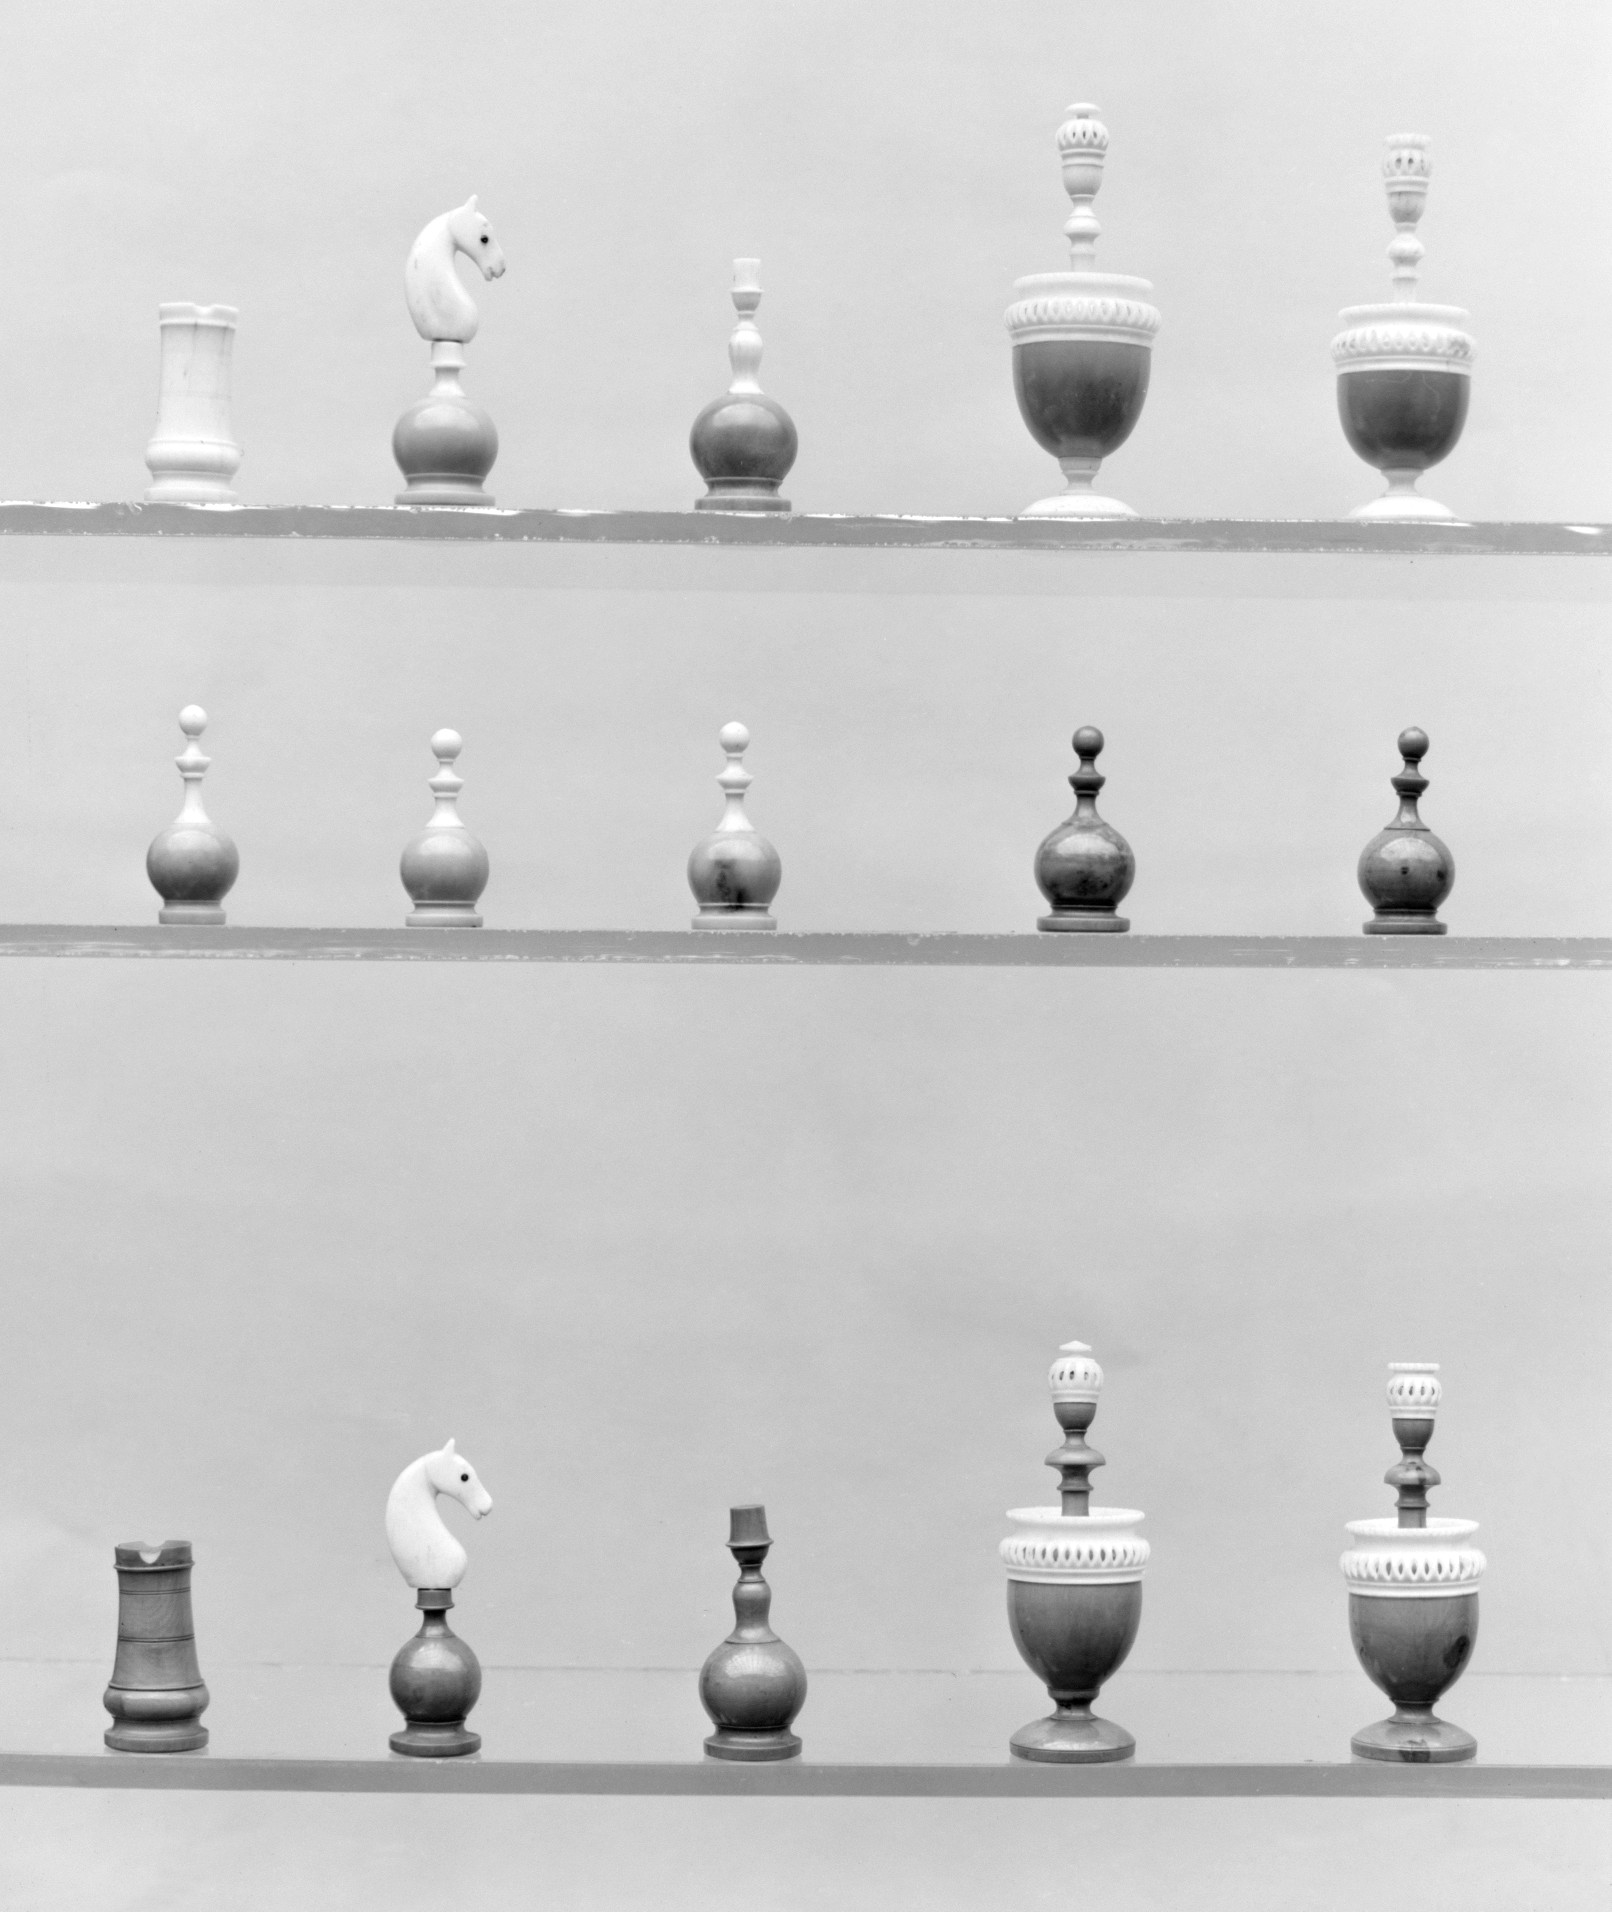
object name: chessman and box board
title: Chessmen, board, and box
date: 1767-1833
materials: bone, ivory, wood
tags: chess